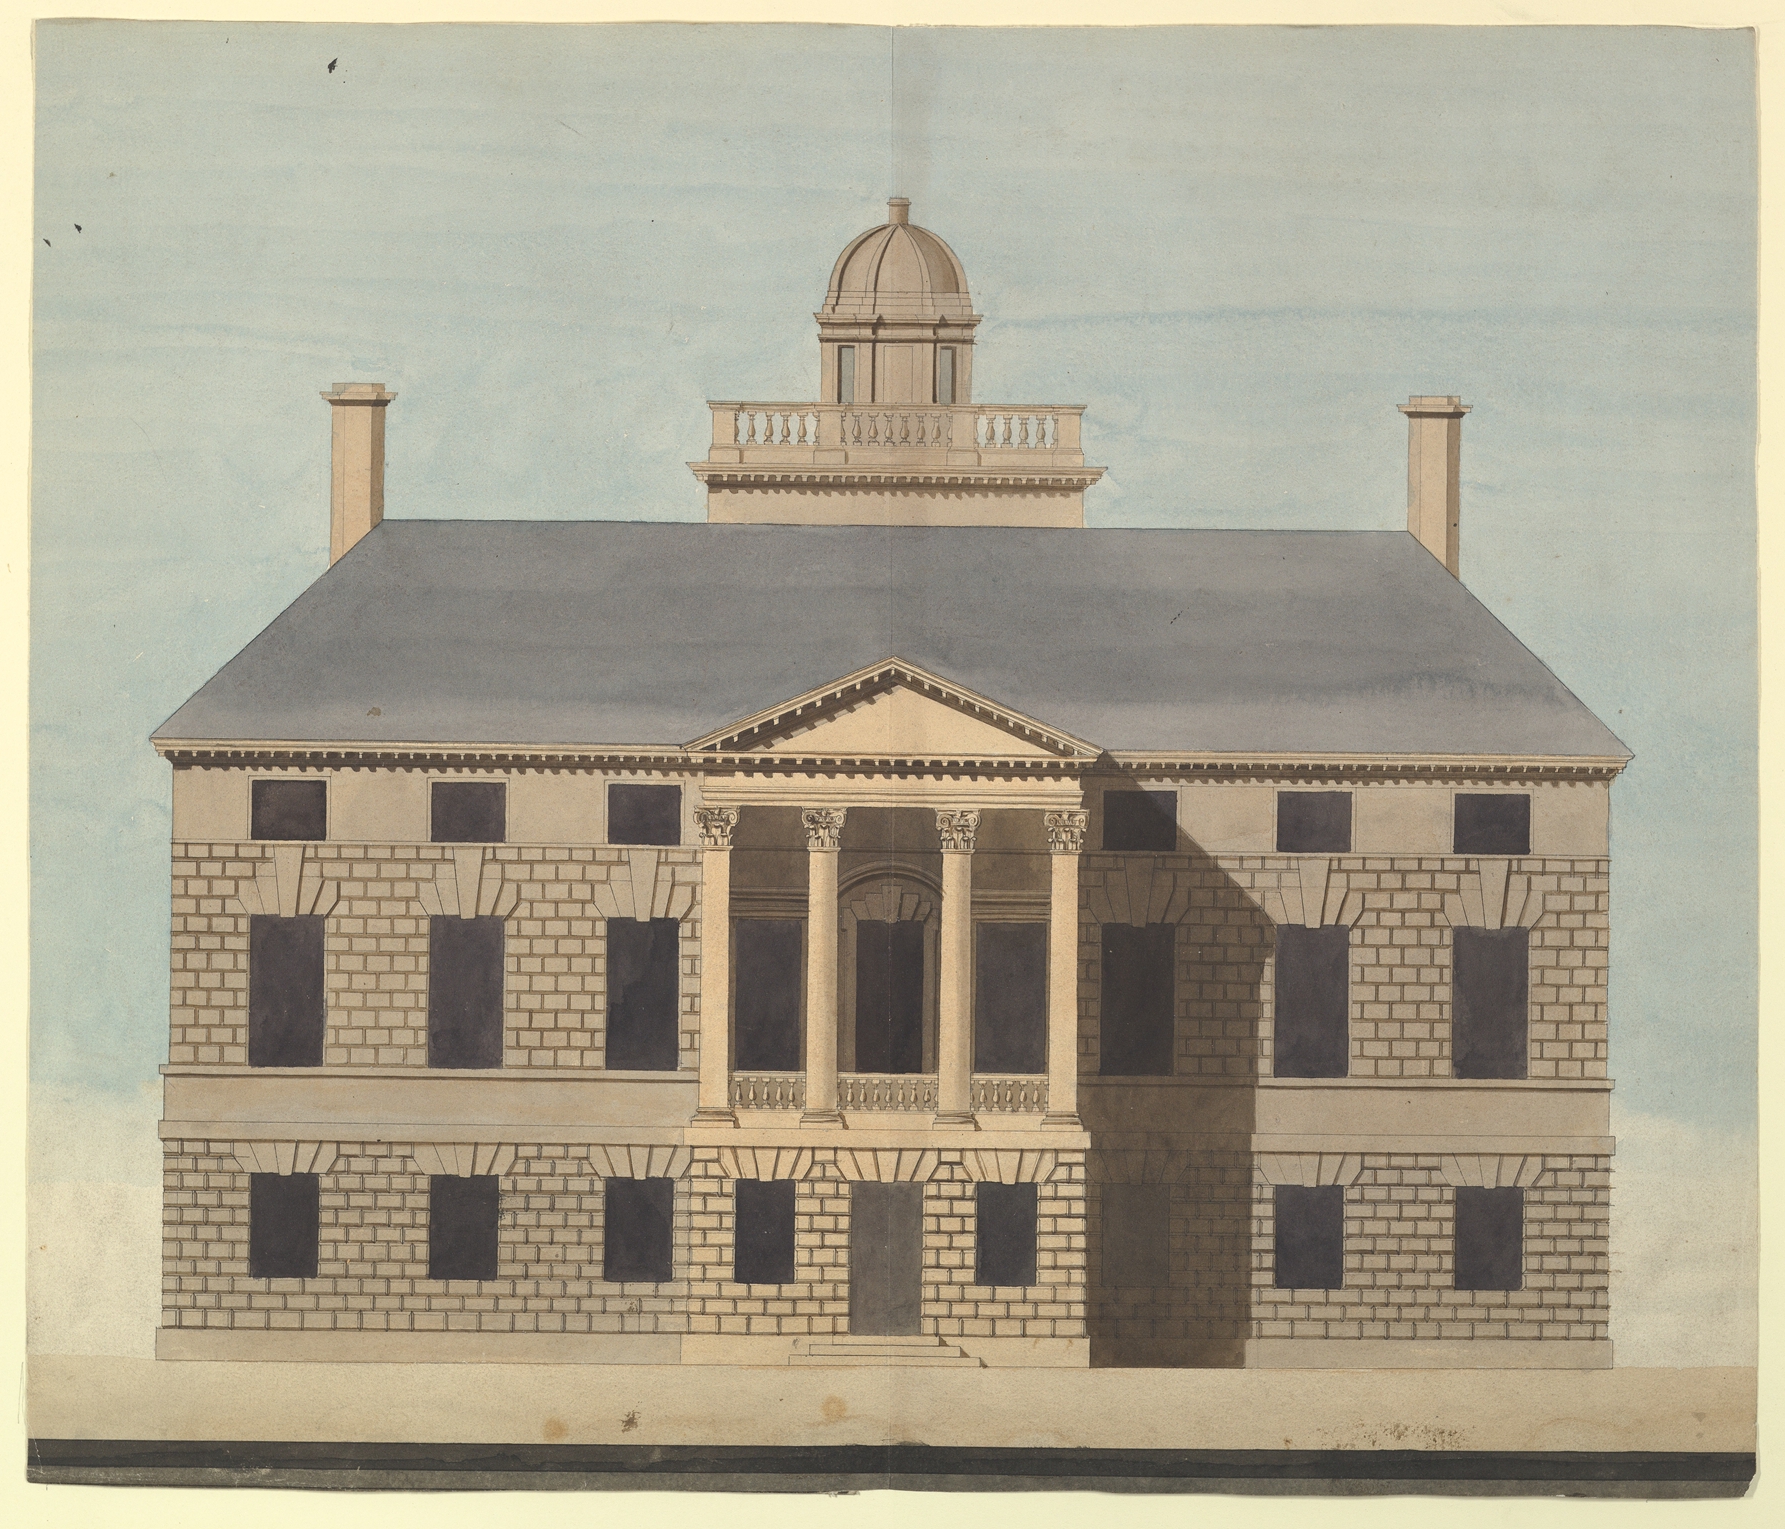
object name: album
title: Album of Architectural Sketches and Drawings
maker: charles james richardson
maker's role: artist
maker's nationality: british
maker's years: 1806-1871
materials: graphite, ink, watercolor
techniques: brush, pen, wash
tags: architecture,buildings